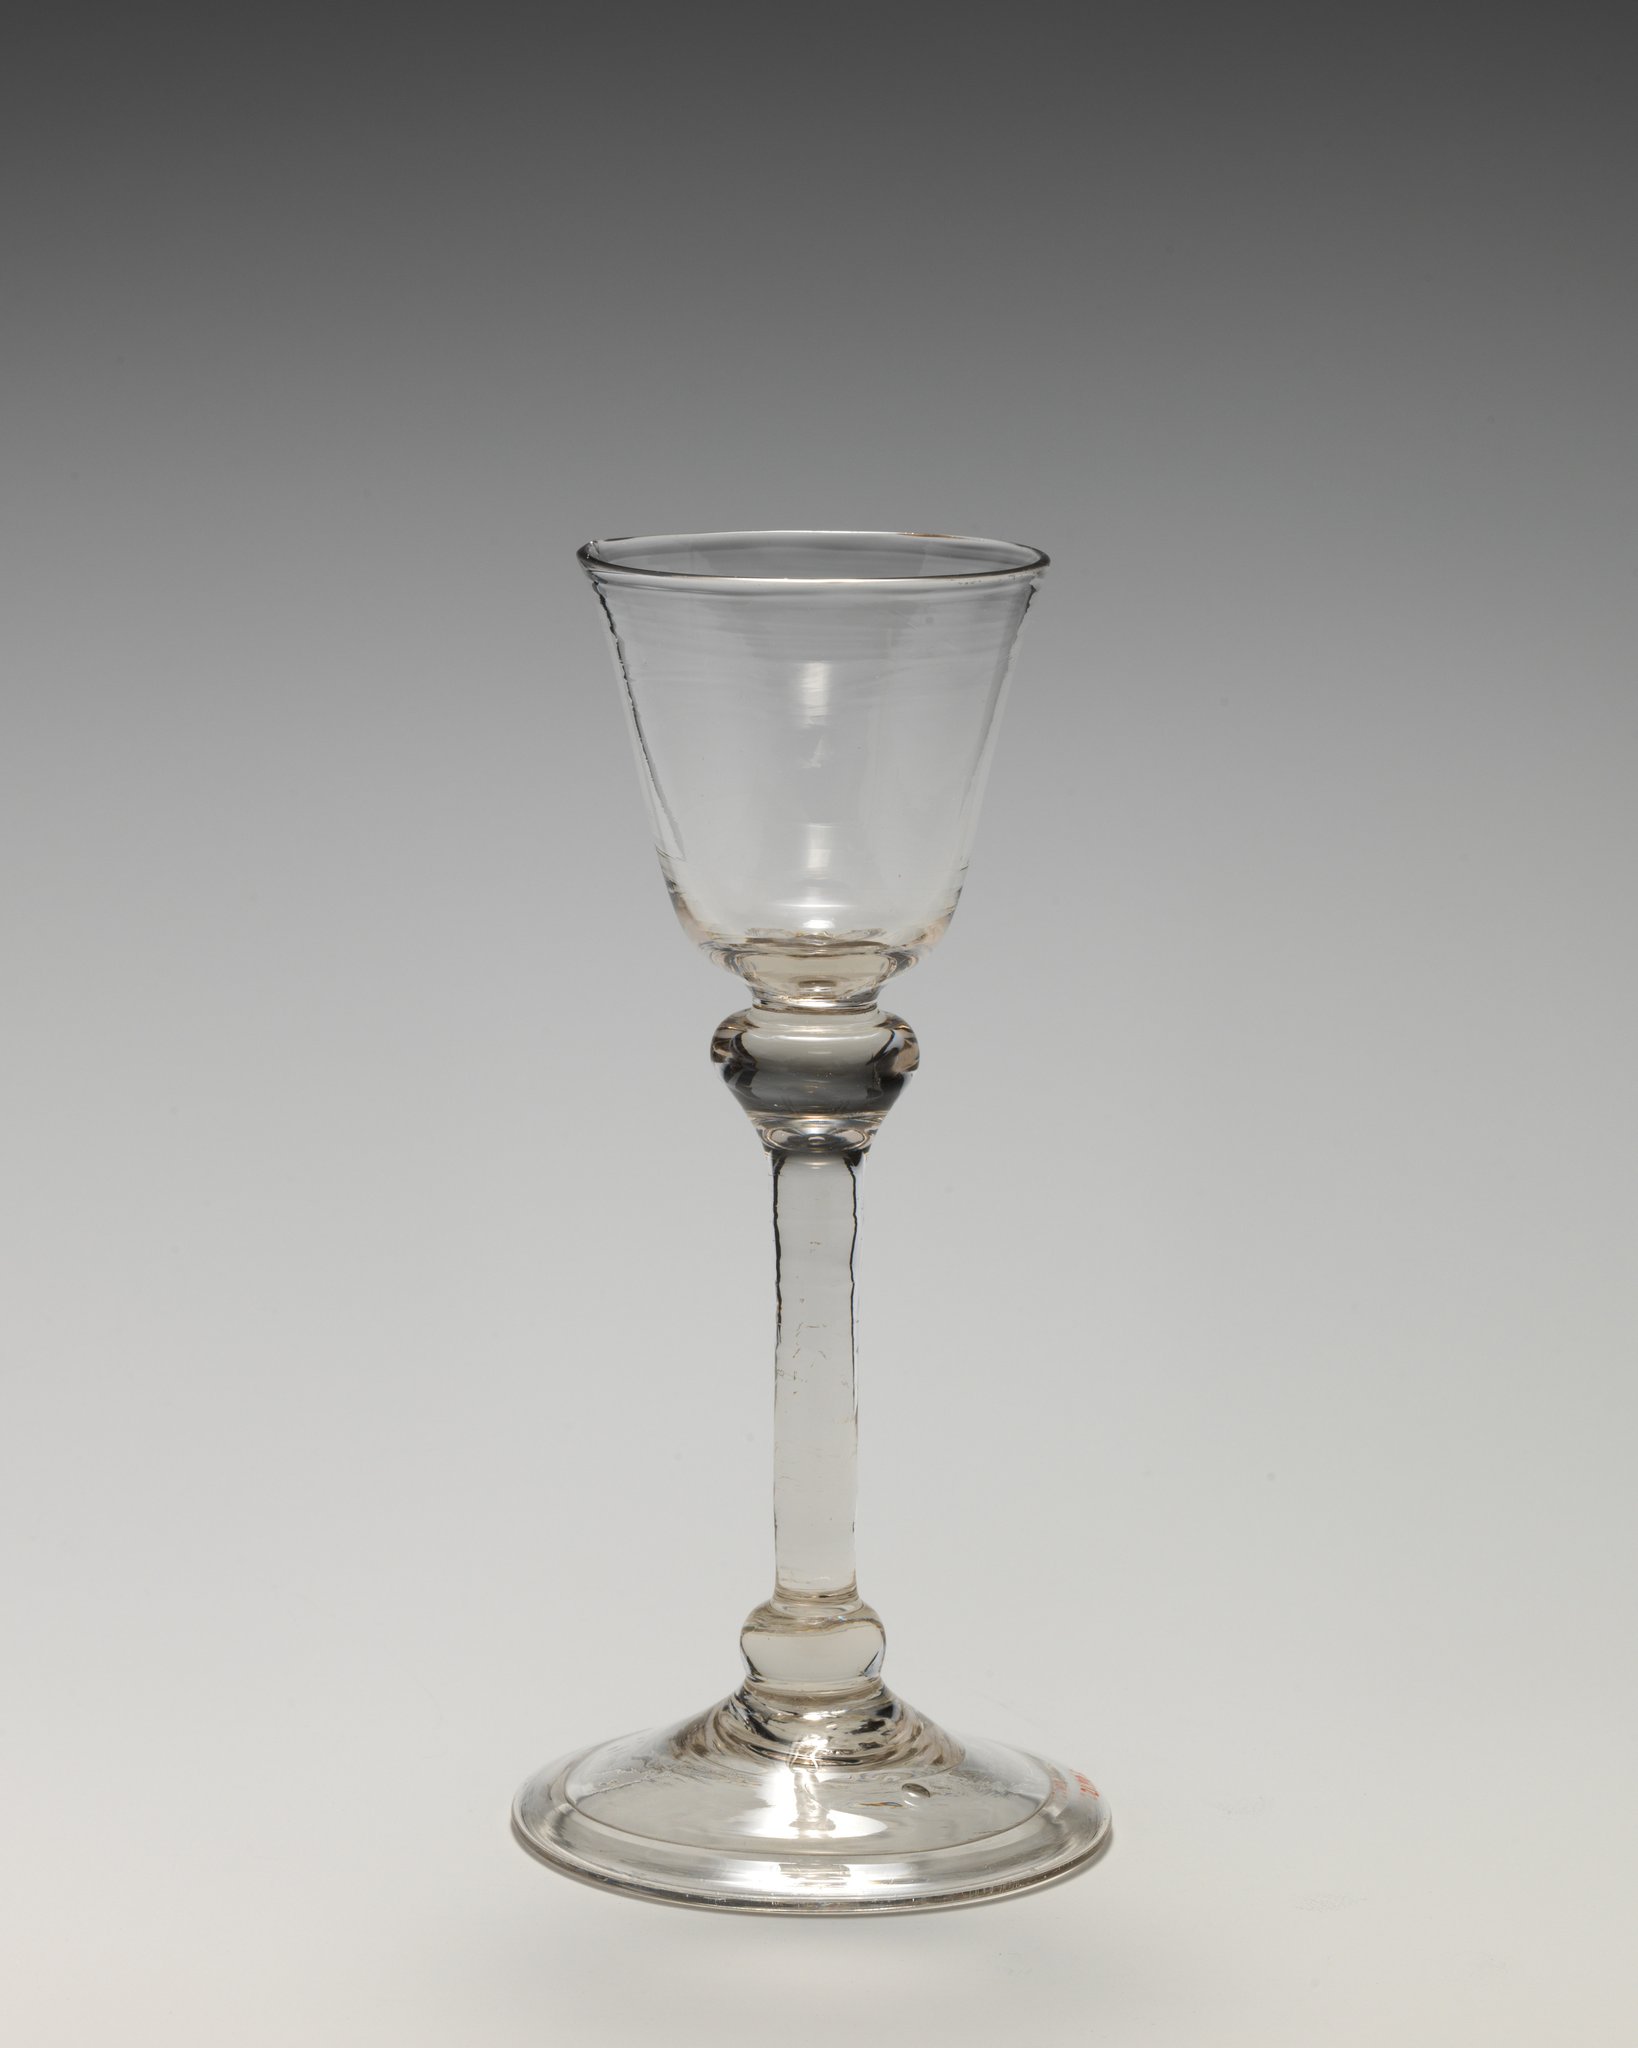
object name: wineglass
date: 1700-1735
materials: glass